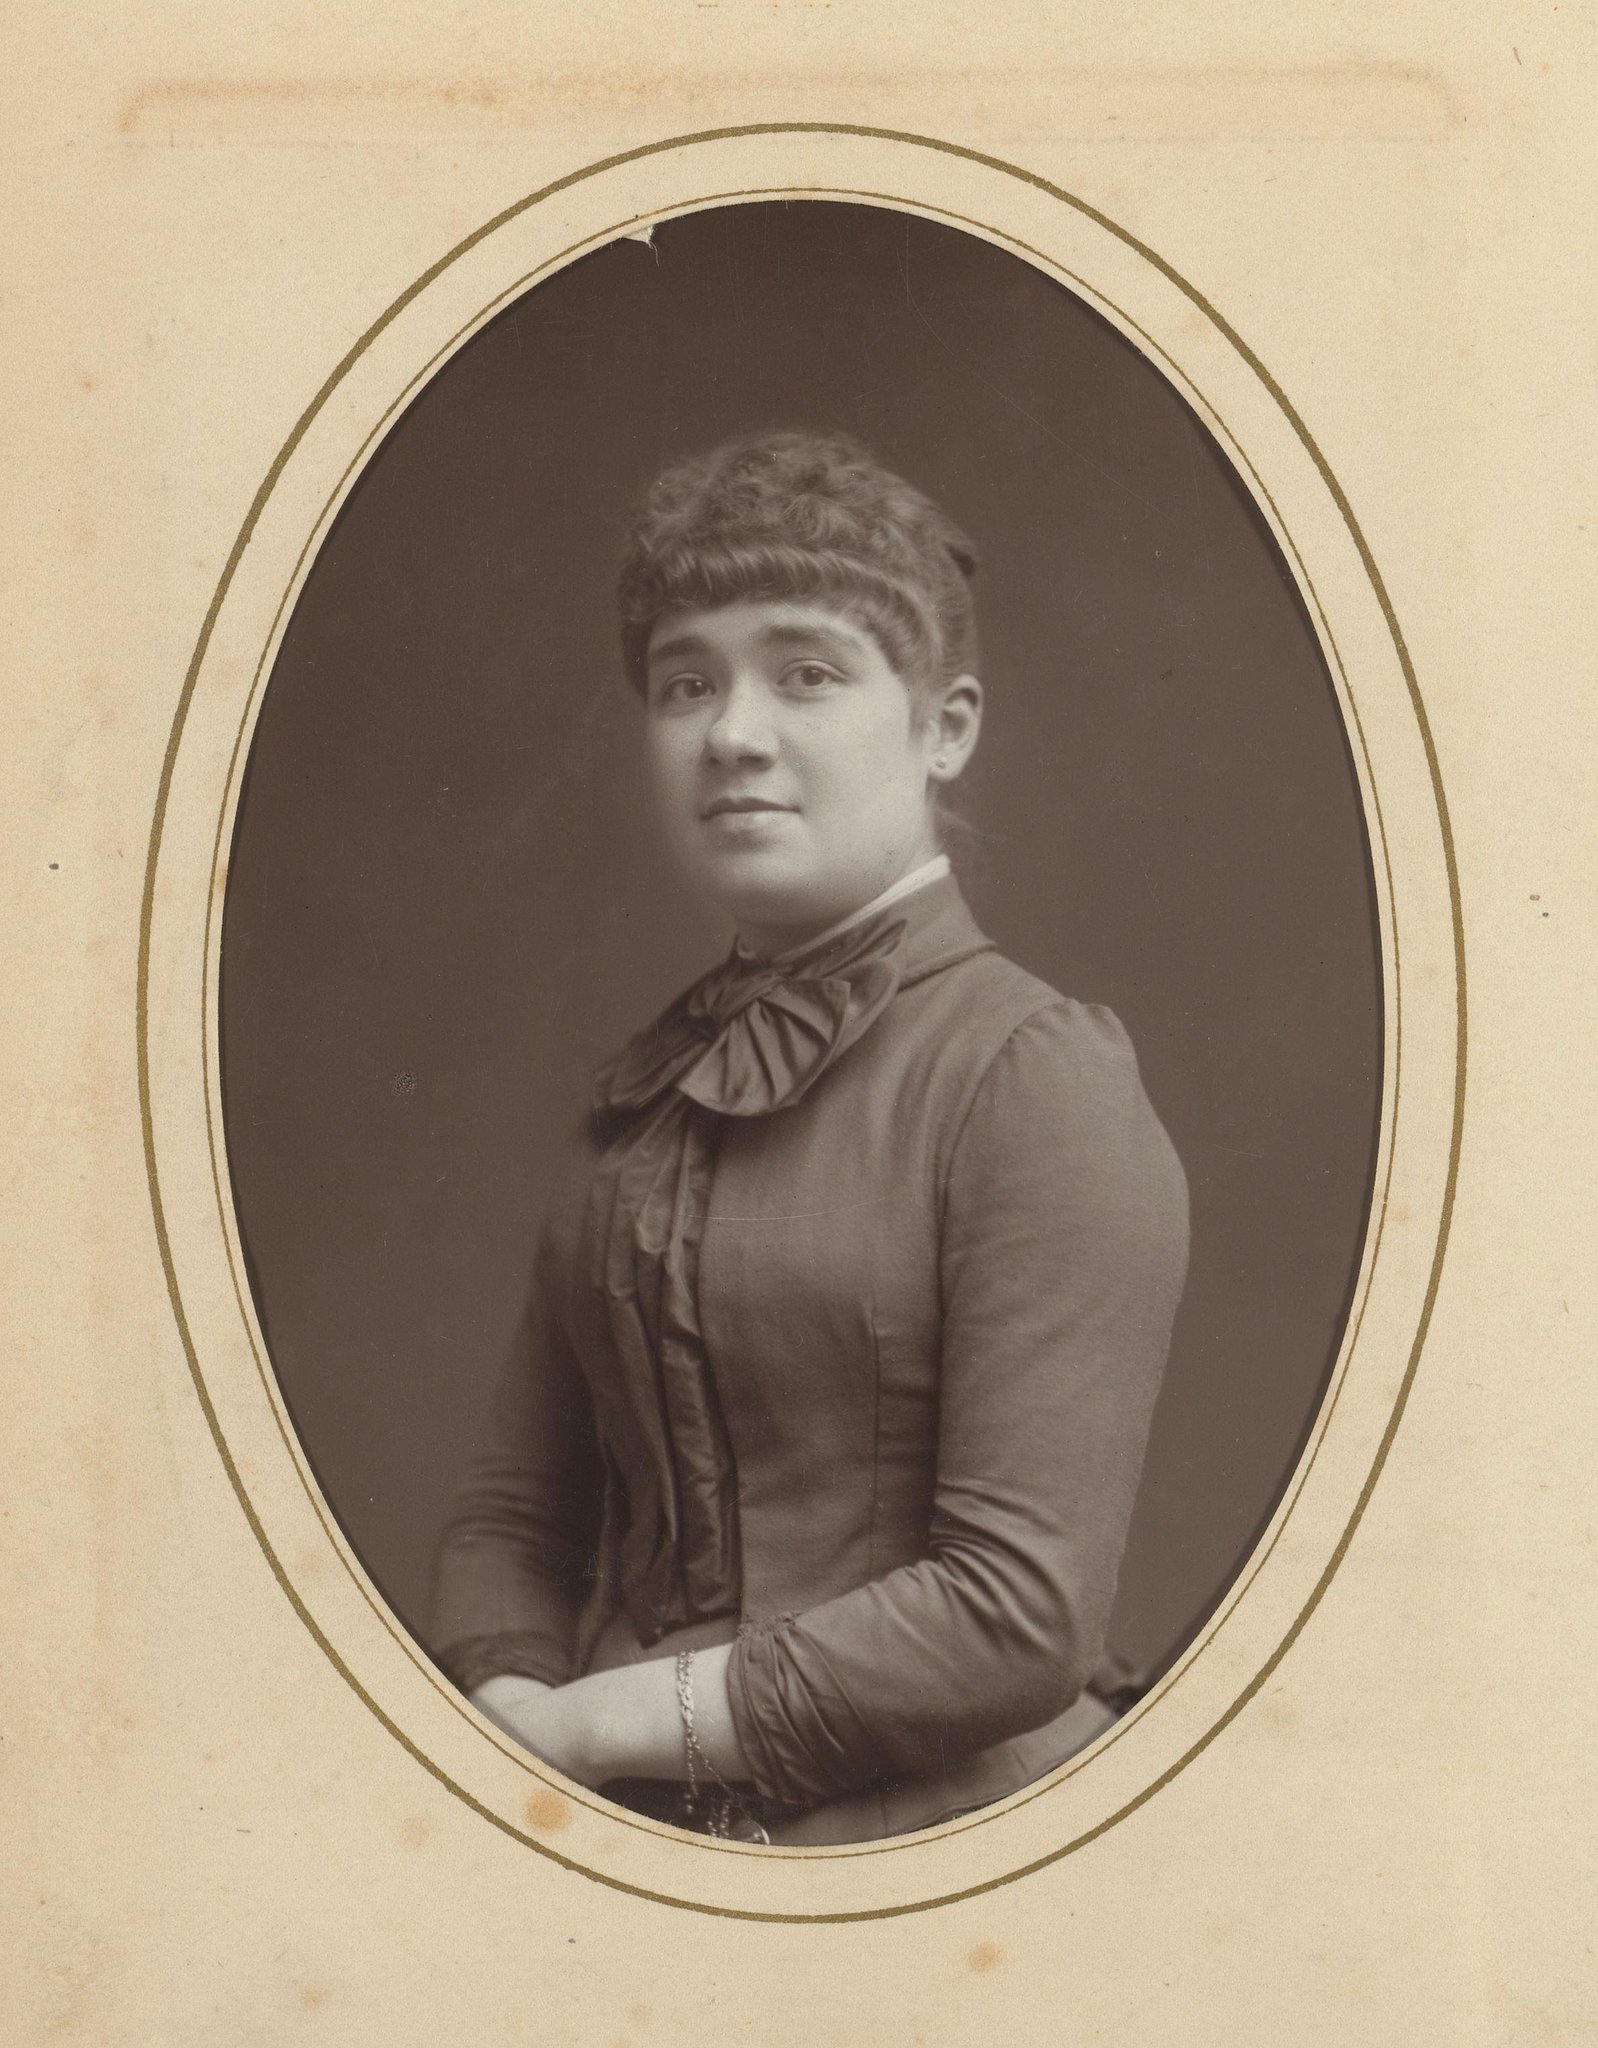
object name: cabinet photograph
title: Portret van een jonge vrouw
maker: paul joseph nicolas nestor schaffers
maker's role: fotograaf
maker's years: 1826-1896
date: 1875-1896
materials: cardboard, photographic support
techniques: carbon print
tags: adolescent, young woman, maiden, historical persons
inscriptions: inscription: ‘Procedé Inaltérable/ Photographie au Charbon/ Nestor Schaffers/ Photographe/ Rue Guinard 9/ Gand’, inscription: ‘Impression inalterable charbon/ Nestor Schaffers, Photographe, Gand’